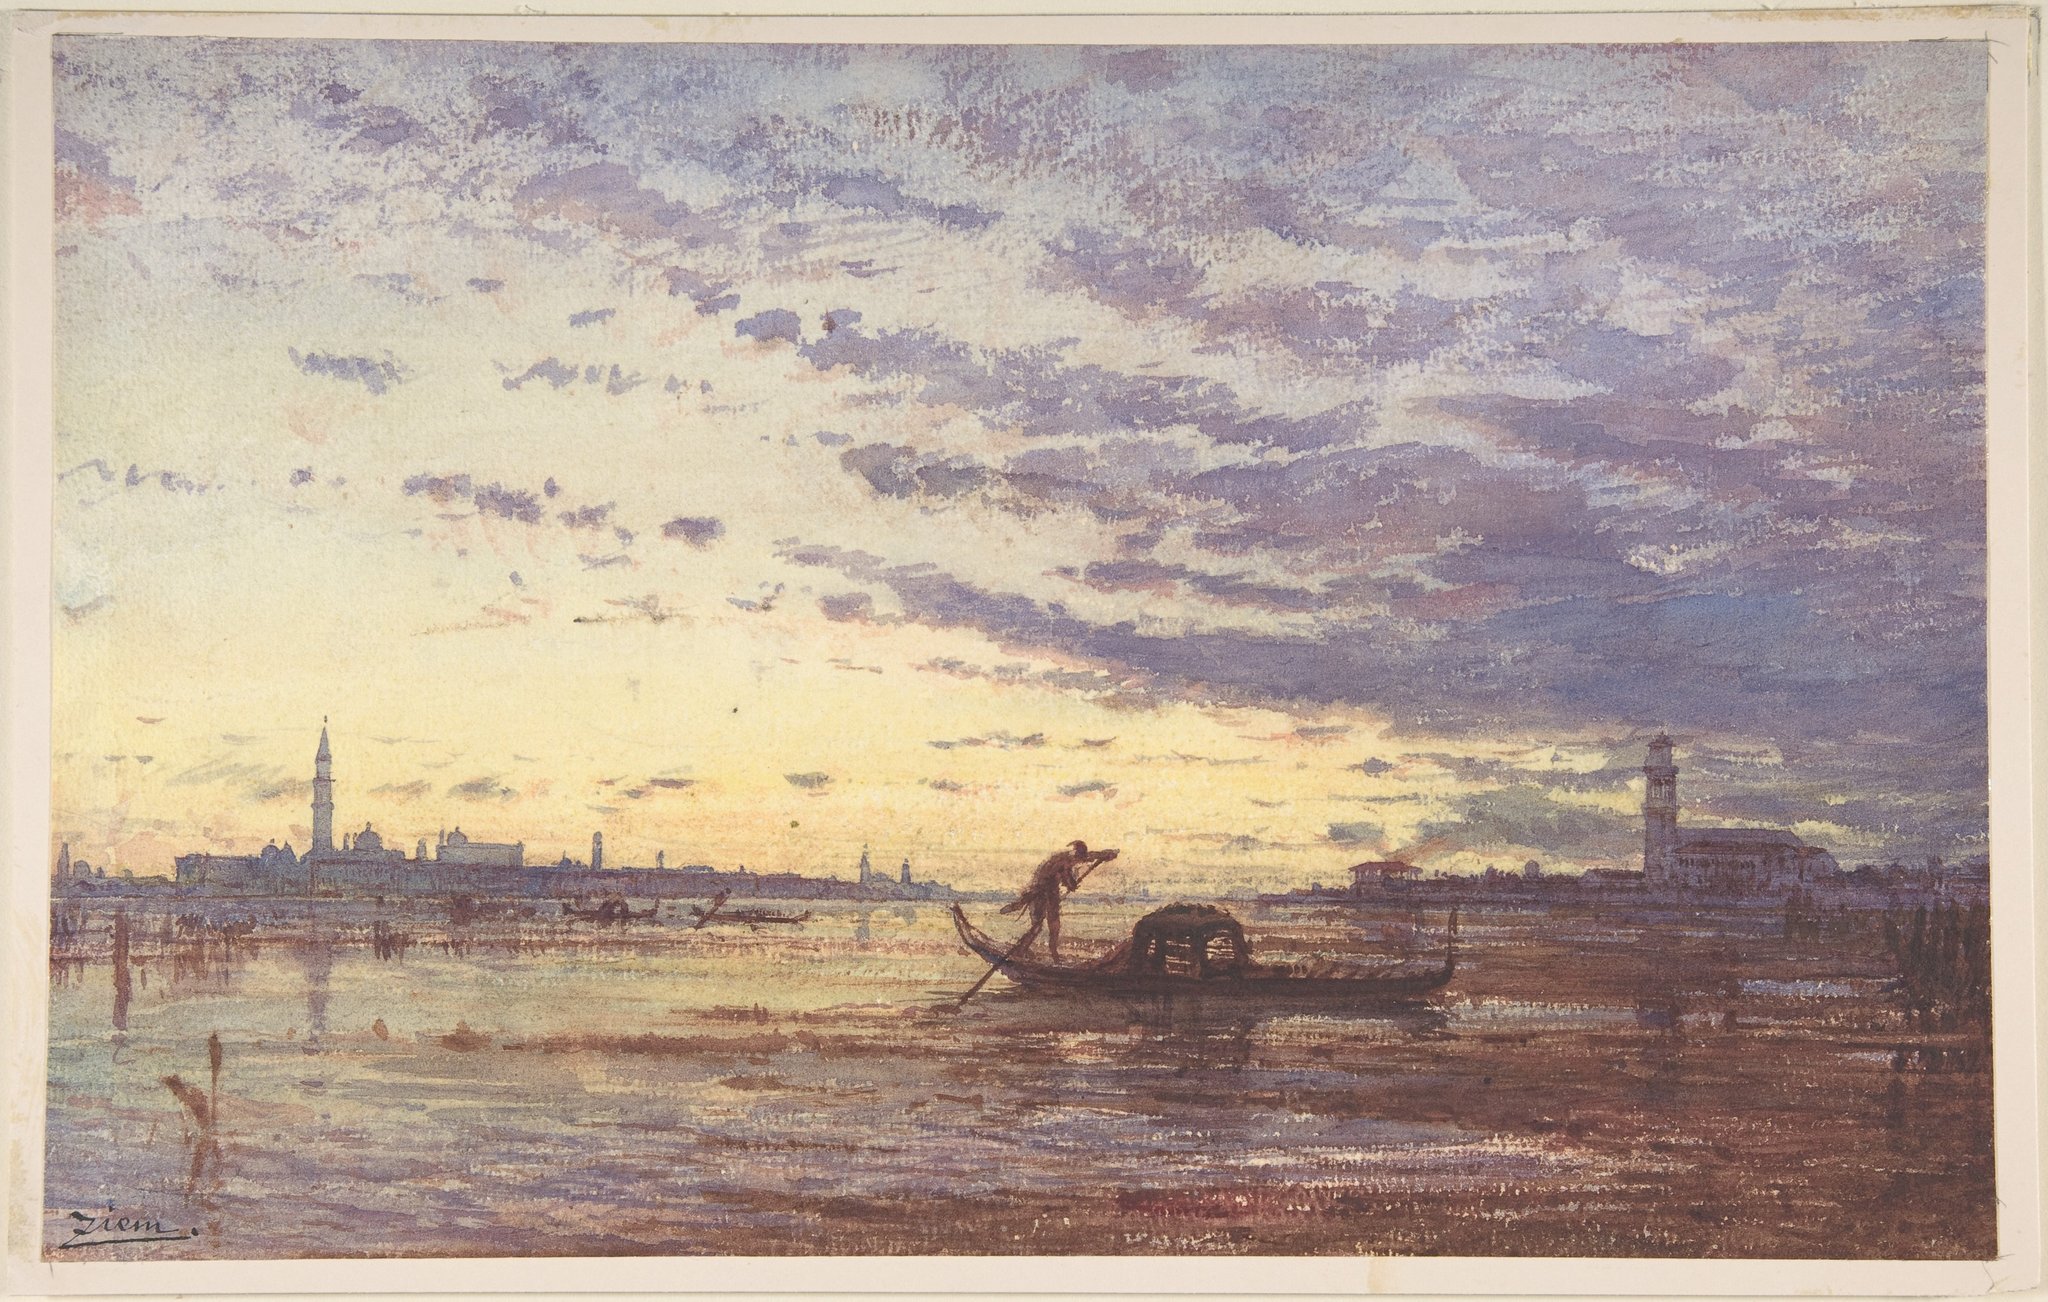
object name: drawing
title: Venice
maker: félix-françois-georges-philibert ziem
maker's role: artist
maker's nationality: french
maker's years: 1821-1911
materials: watercolor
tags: buildings,clouds,boats,venice